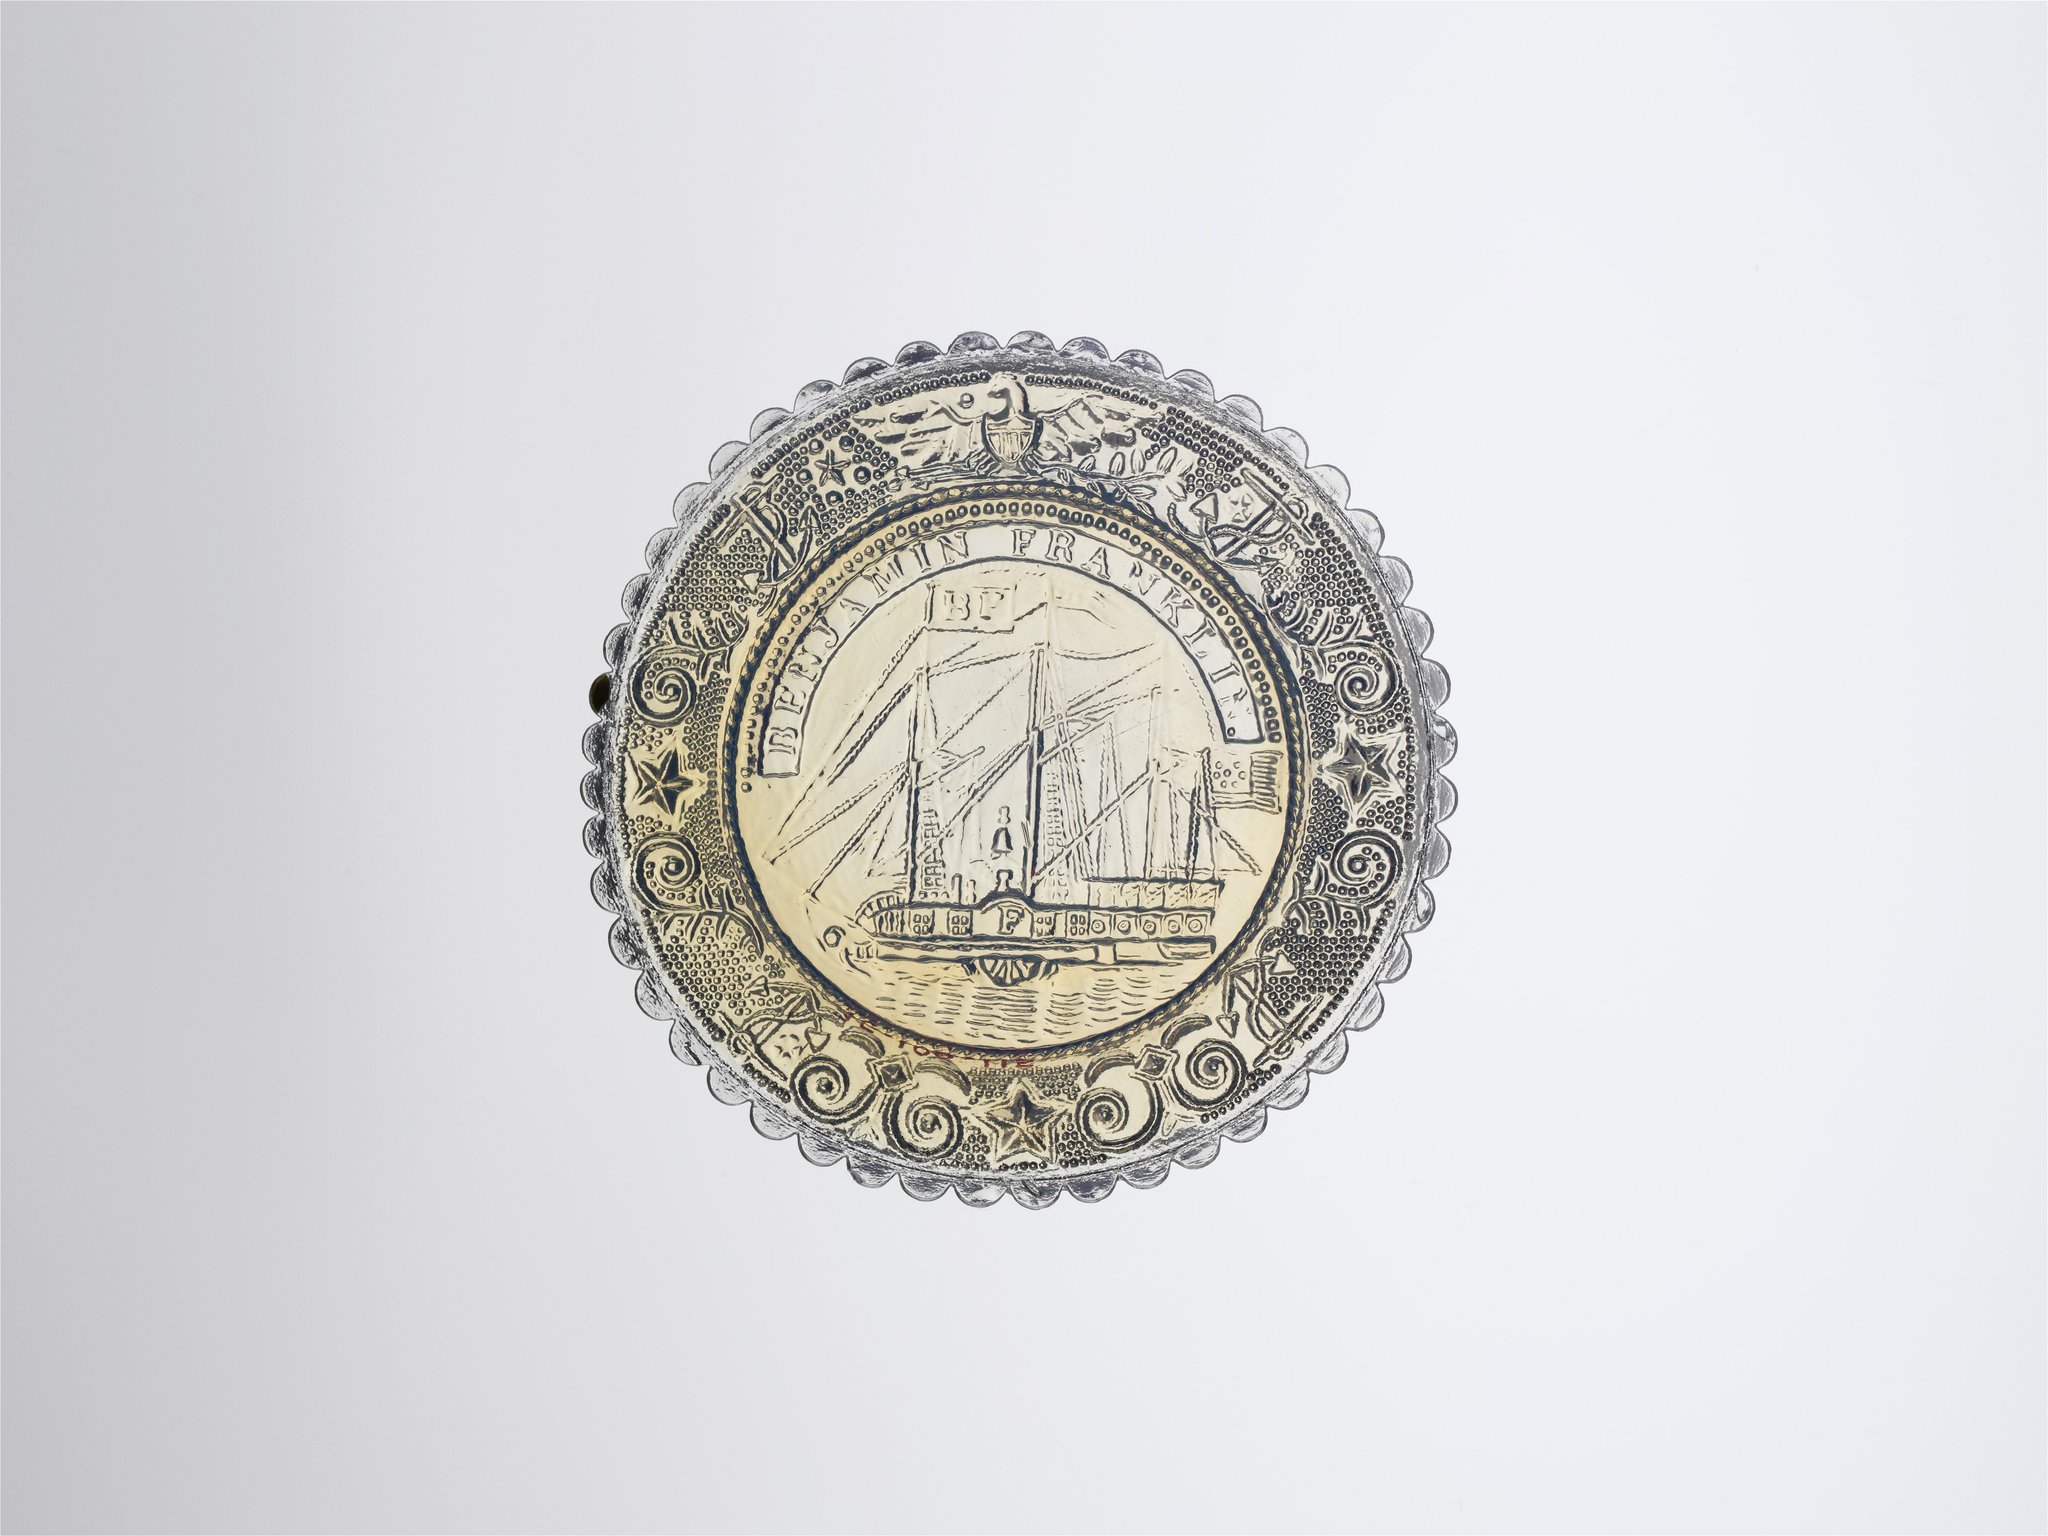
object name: cup plate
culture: american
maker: boston & sandwich glass company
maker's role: maker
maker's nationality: american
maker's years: 1825-1888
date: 1829-1840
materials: glass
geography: united states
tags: ships